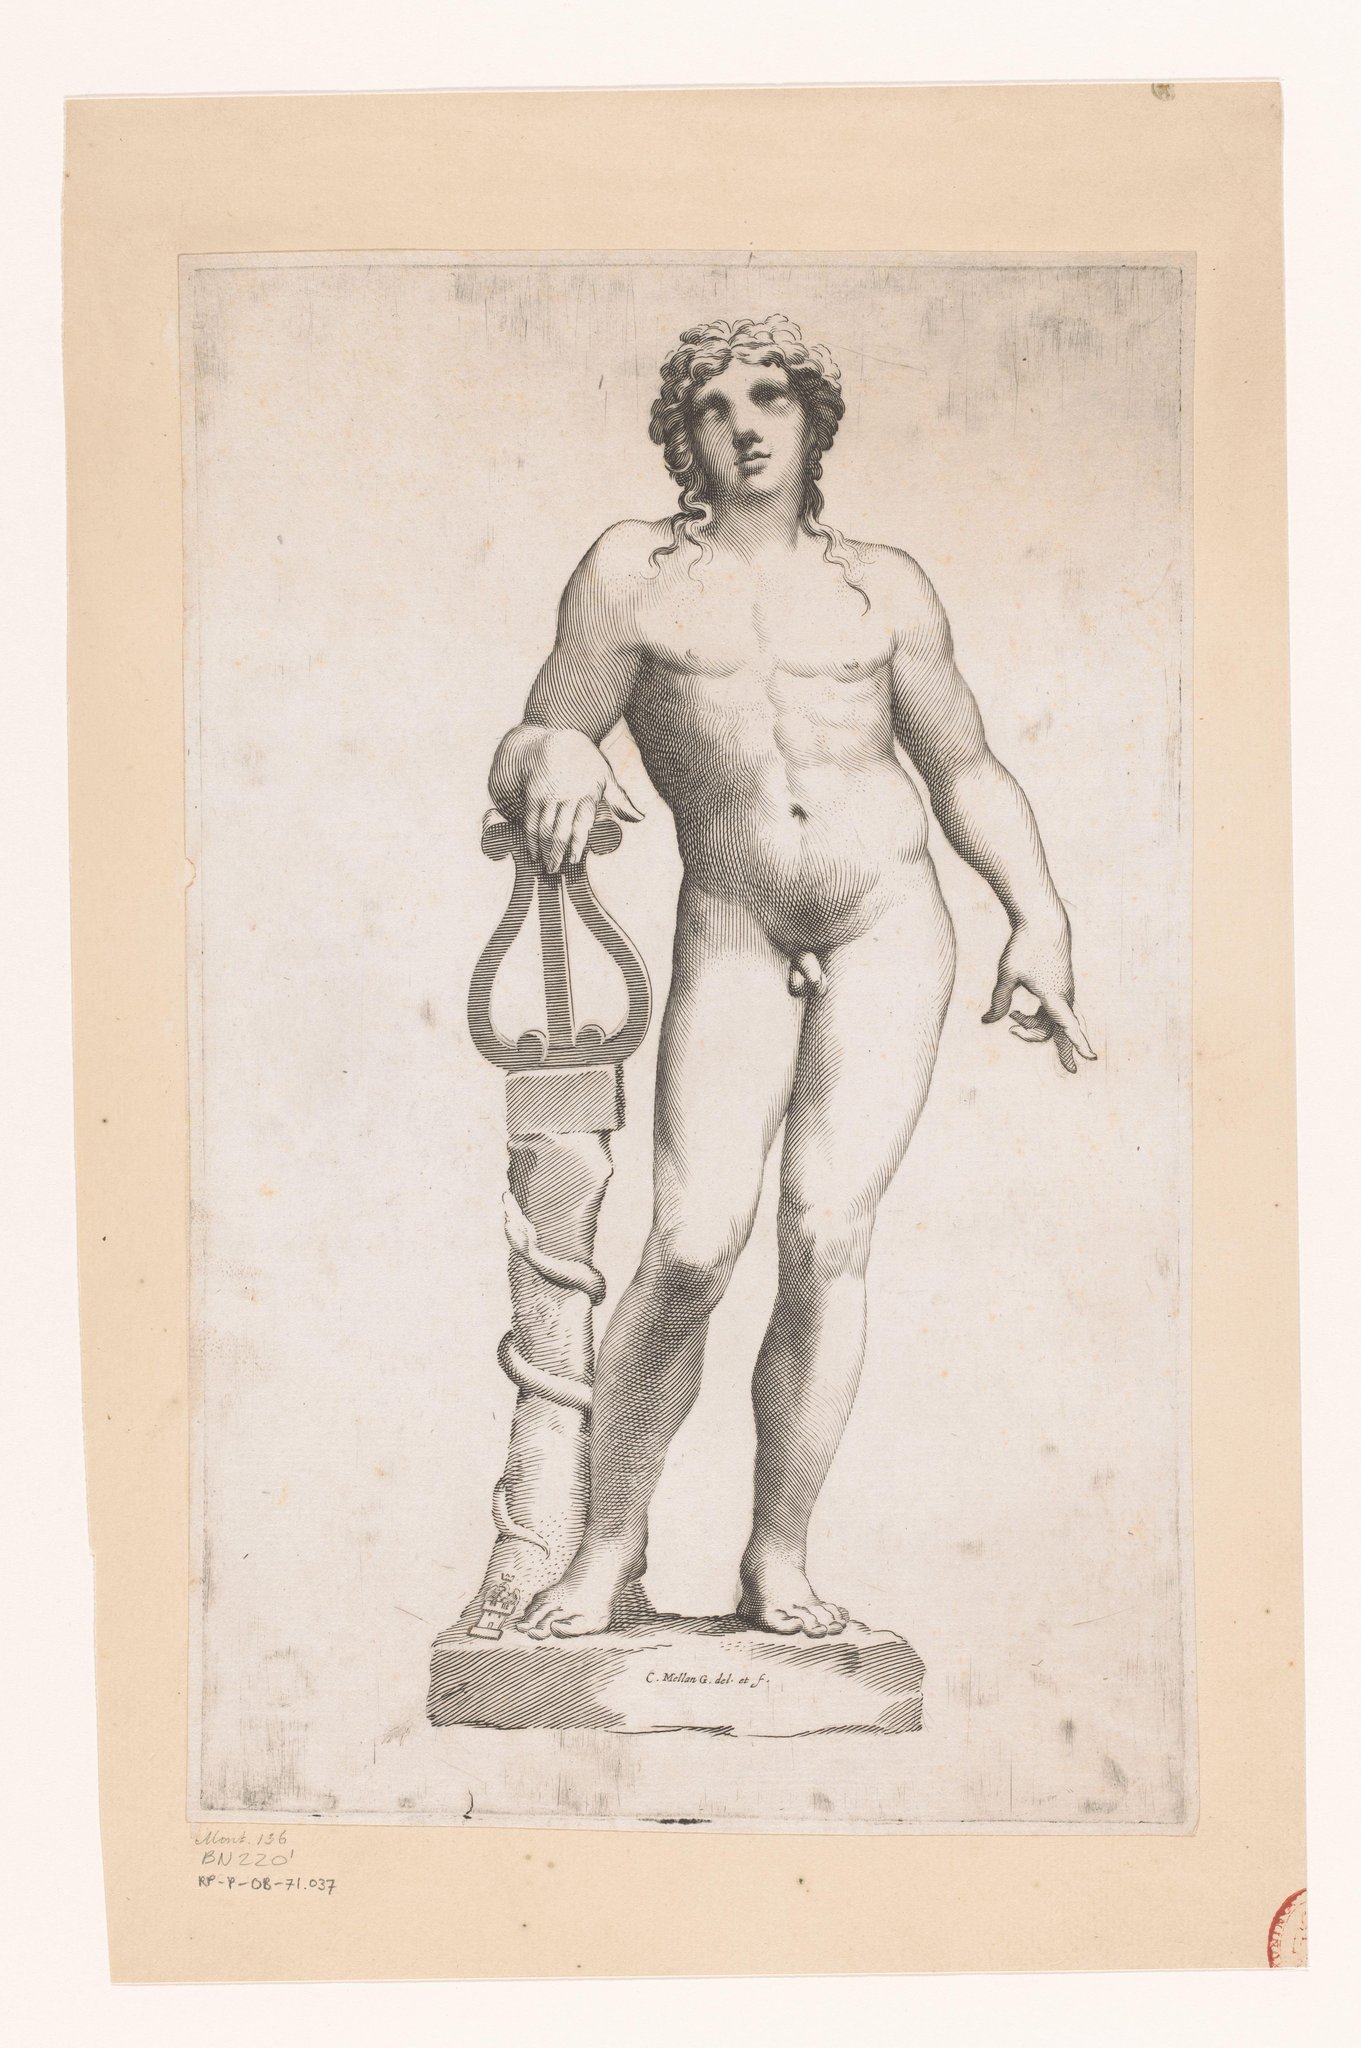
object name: print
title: Kunstwerken uit de collectie van Vincenzo Giustiniani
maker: claude mellan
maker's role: draughtsman, print maker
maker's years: 1598-1688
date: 1631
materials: paper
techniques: engraving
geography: rome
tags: rome, vincenzo giustiniani (1564-1637), (story of) apollo (phoebus), piece of sculpture, reproduction of a piece of sculpture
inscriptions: collector's mark: Lugt 240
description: Maakt deel uit van een serie bestaande uit 322 prenten van kunstwerken uit de collectie van Vincenzo Giustiniani die in twee volumes werd uitgegeven door Joachim von Sandrart in 1636 en 1637 (zie British Museum, inv.nr. 1851,1213.565). De serie bestaat uit prenten door verschillende kunstenaars zoals Cornelis Bloemaert, Theodore Matham, Pieter de Bailliu en Michel Natalis. Claude Mellan was verantwoordelijk voor 22 prenten van standbeelden en het 1631 gedateerde portret van Giustiniani.